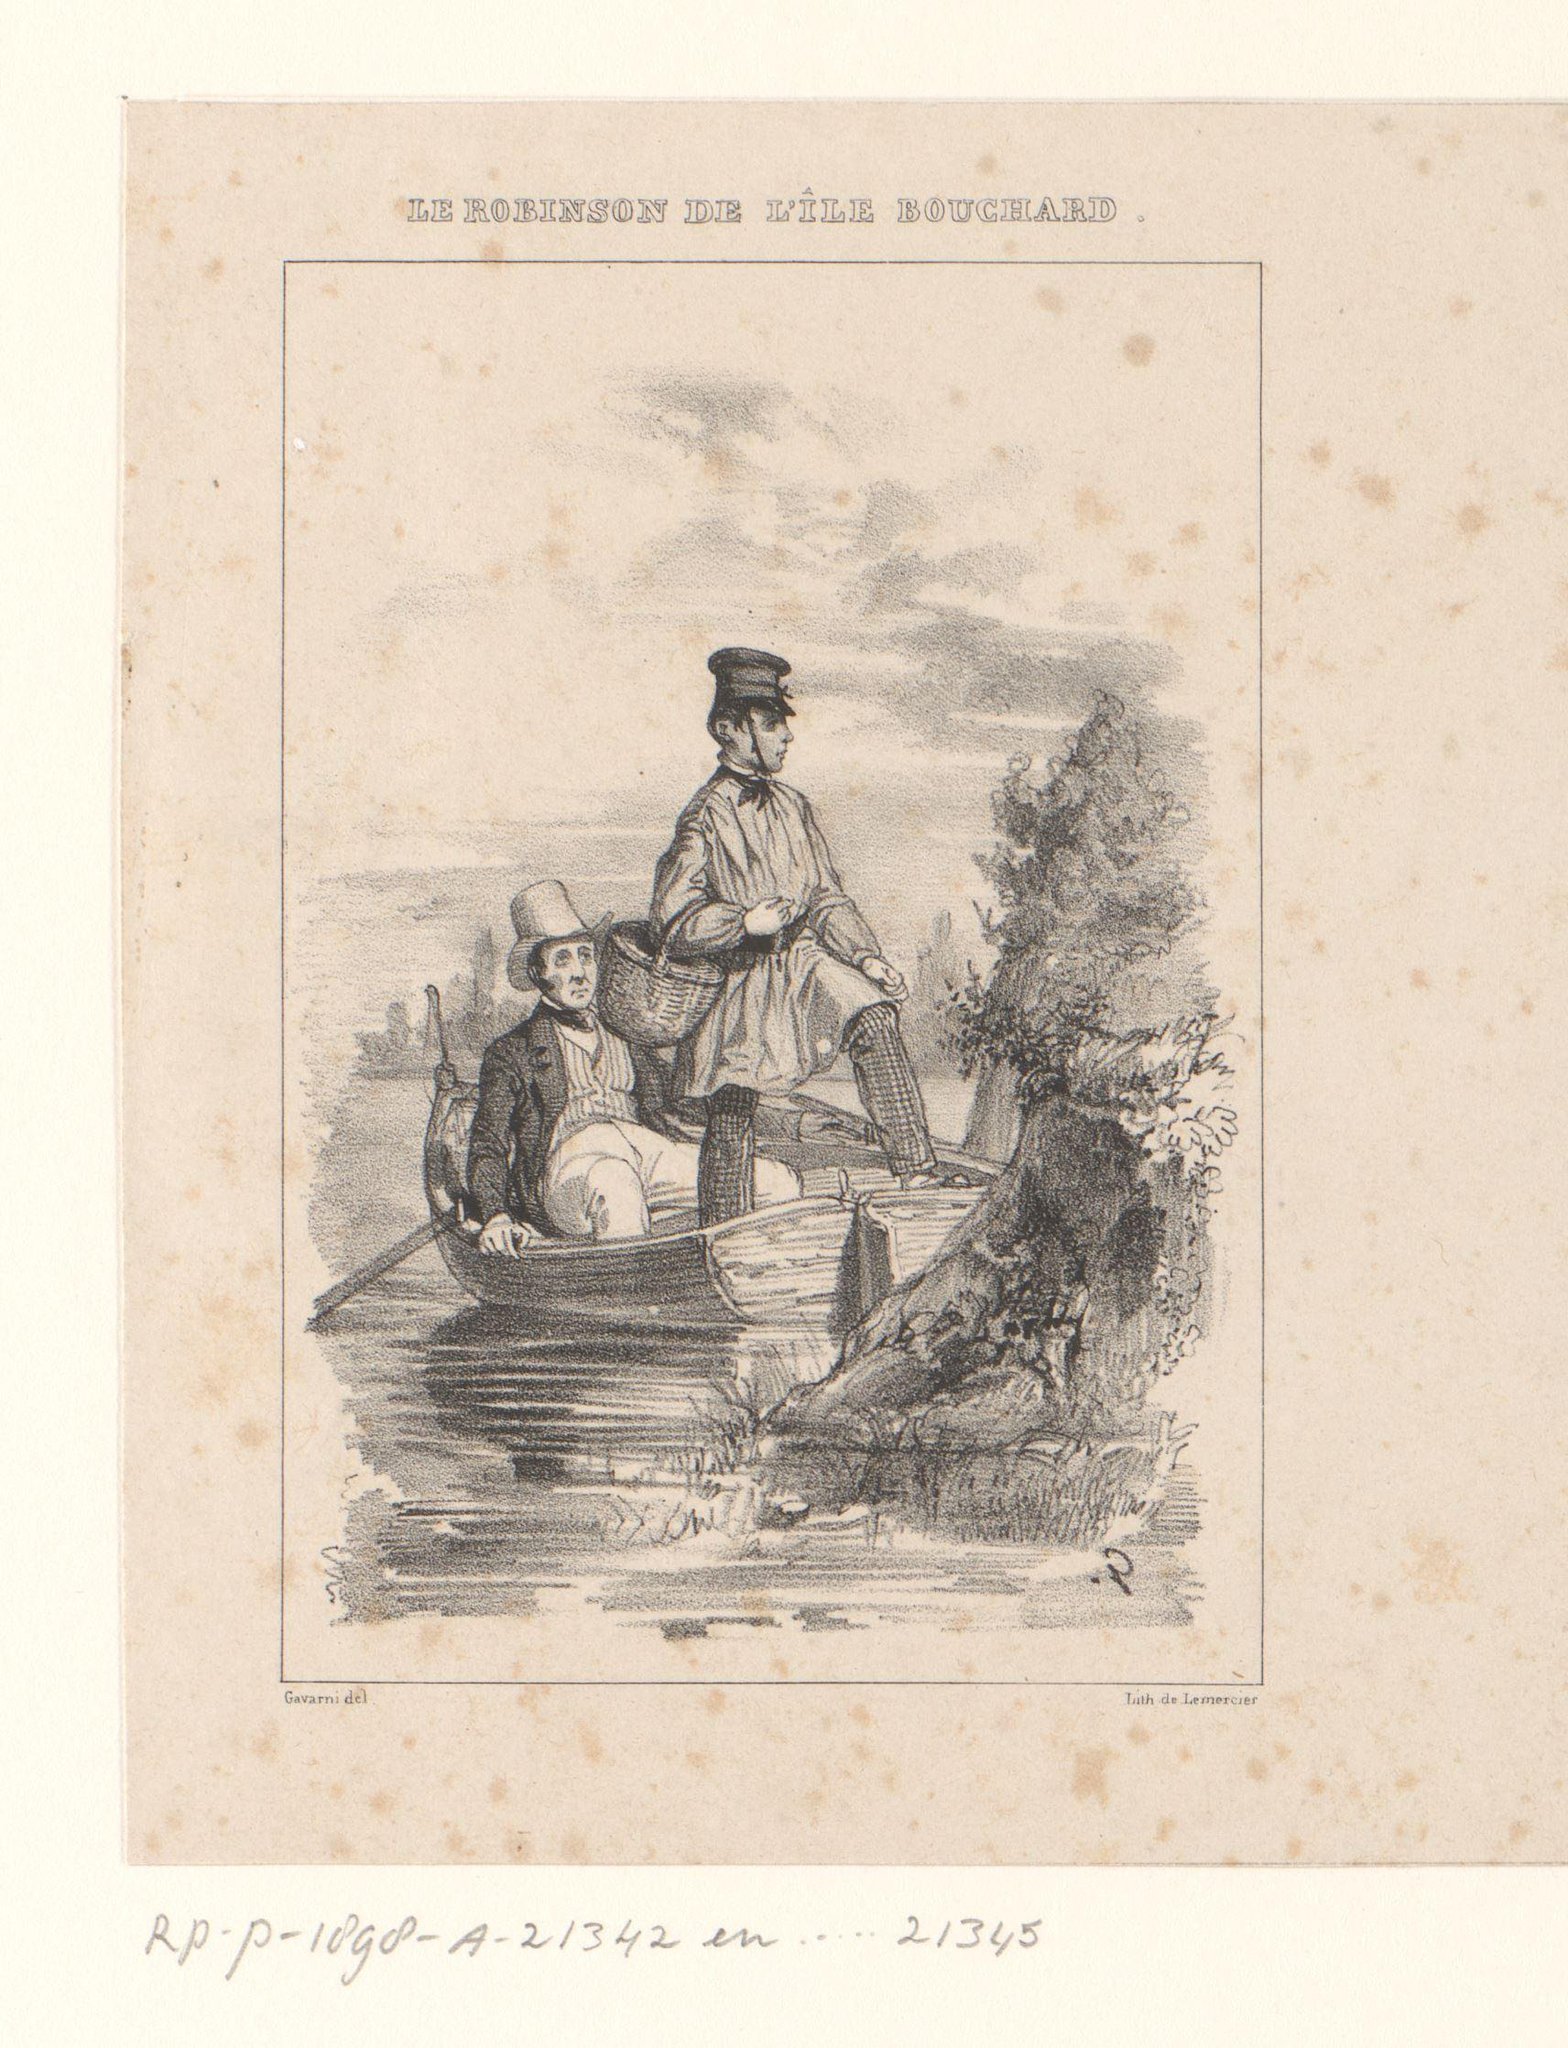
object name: print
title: Twee mannen meren aan op een eiland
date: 1835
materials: paper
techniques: lithograph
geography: paris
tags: island, rowing-boat, canoe, etc., explorer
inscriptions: collector's mark: Lugt 964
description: Prent gebruikt voor: Le Courrier des enfants, 10 augustus 1835.